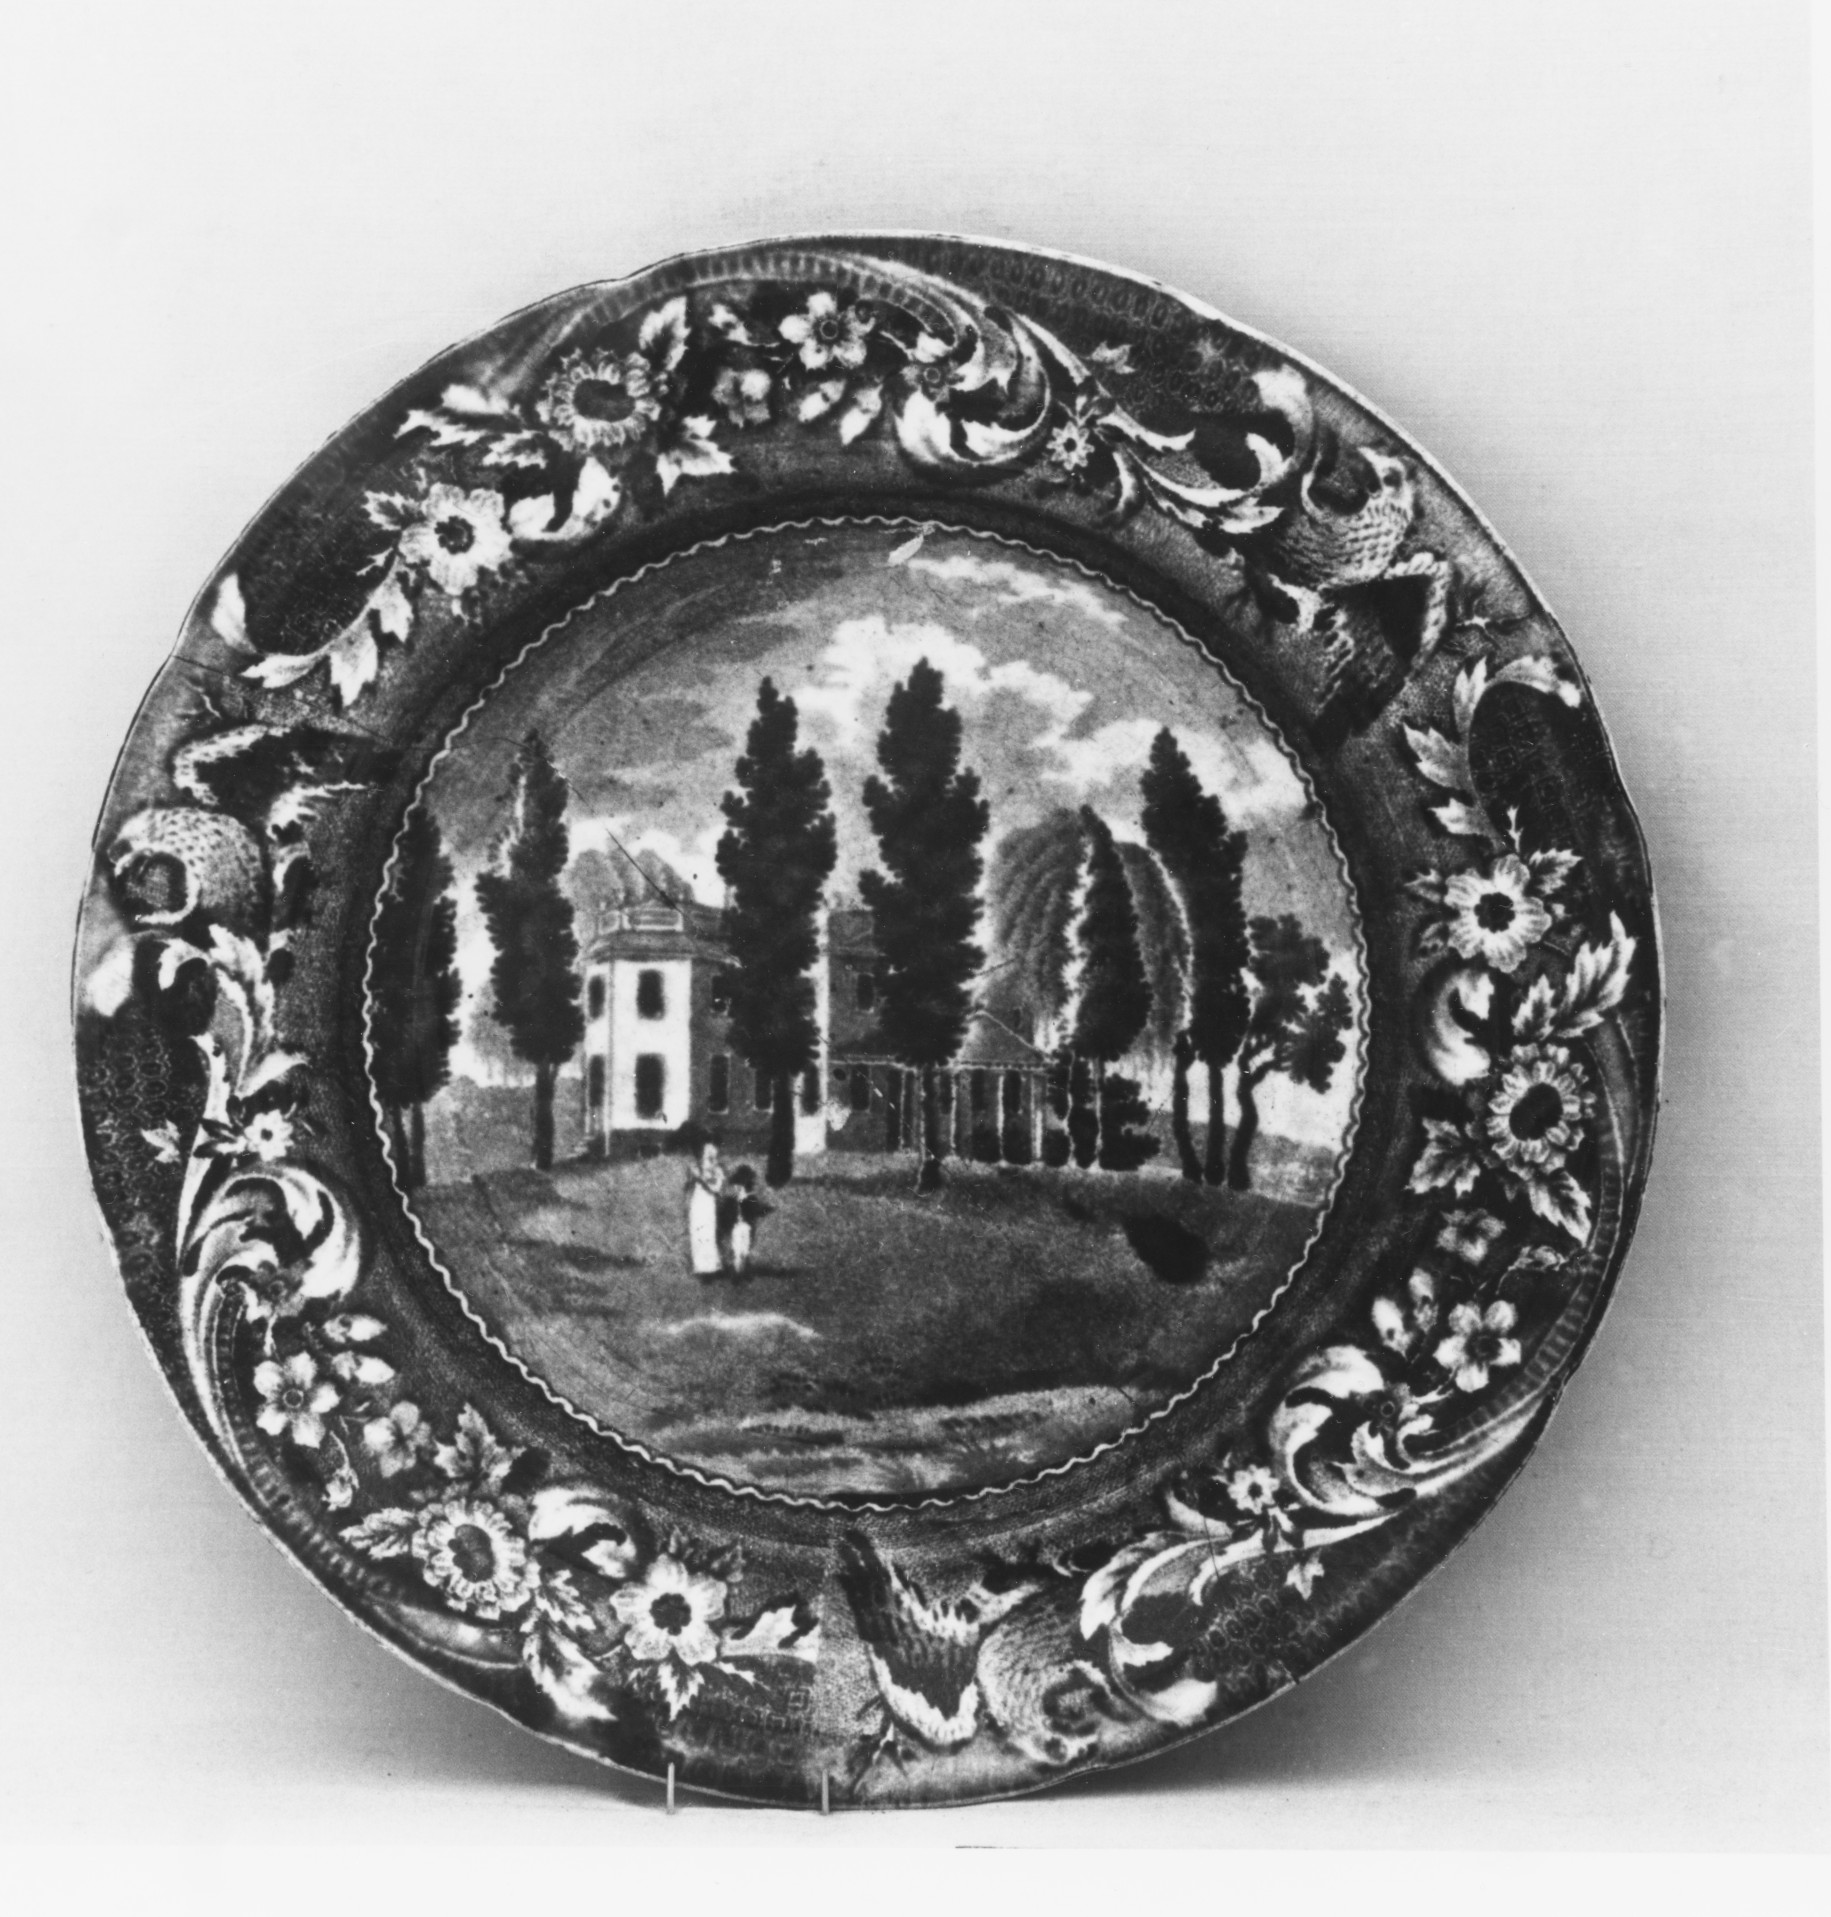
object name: plate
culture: british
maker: joseph stubbs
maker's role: maker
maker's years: 1819-1836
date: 1822-1836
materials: earthenware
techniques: transfer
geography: england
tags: birds,landscapes